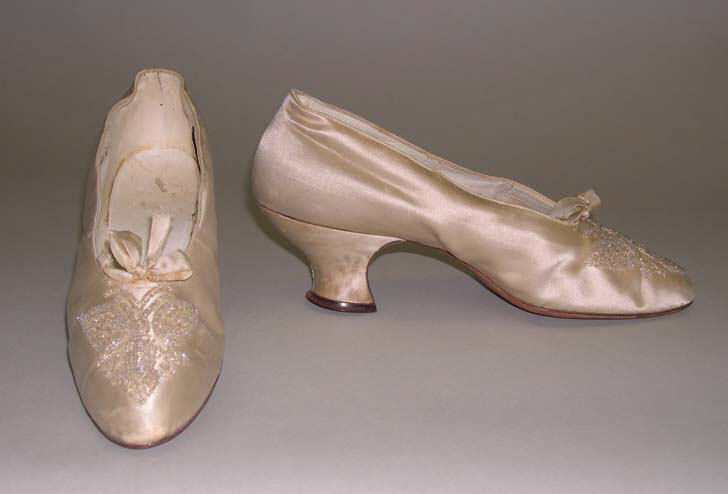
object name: shoe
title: Shoes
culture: american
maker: alexander's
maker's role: department store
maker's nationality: american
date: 1900